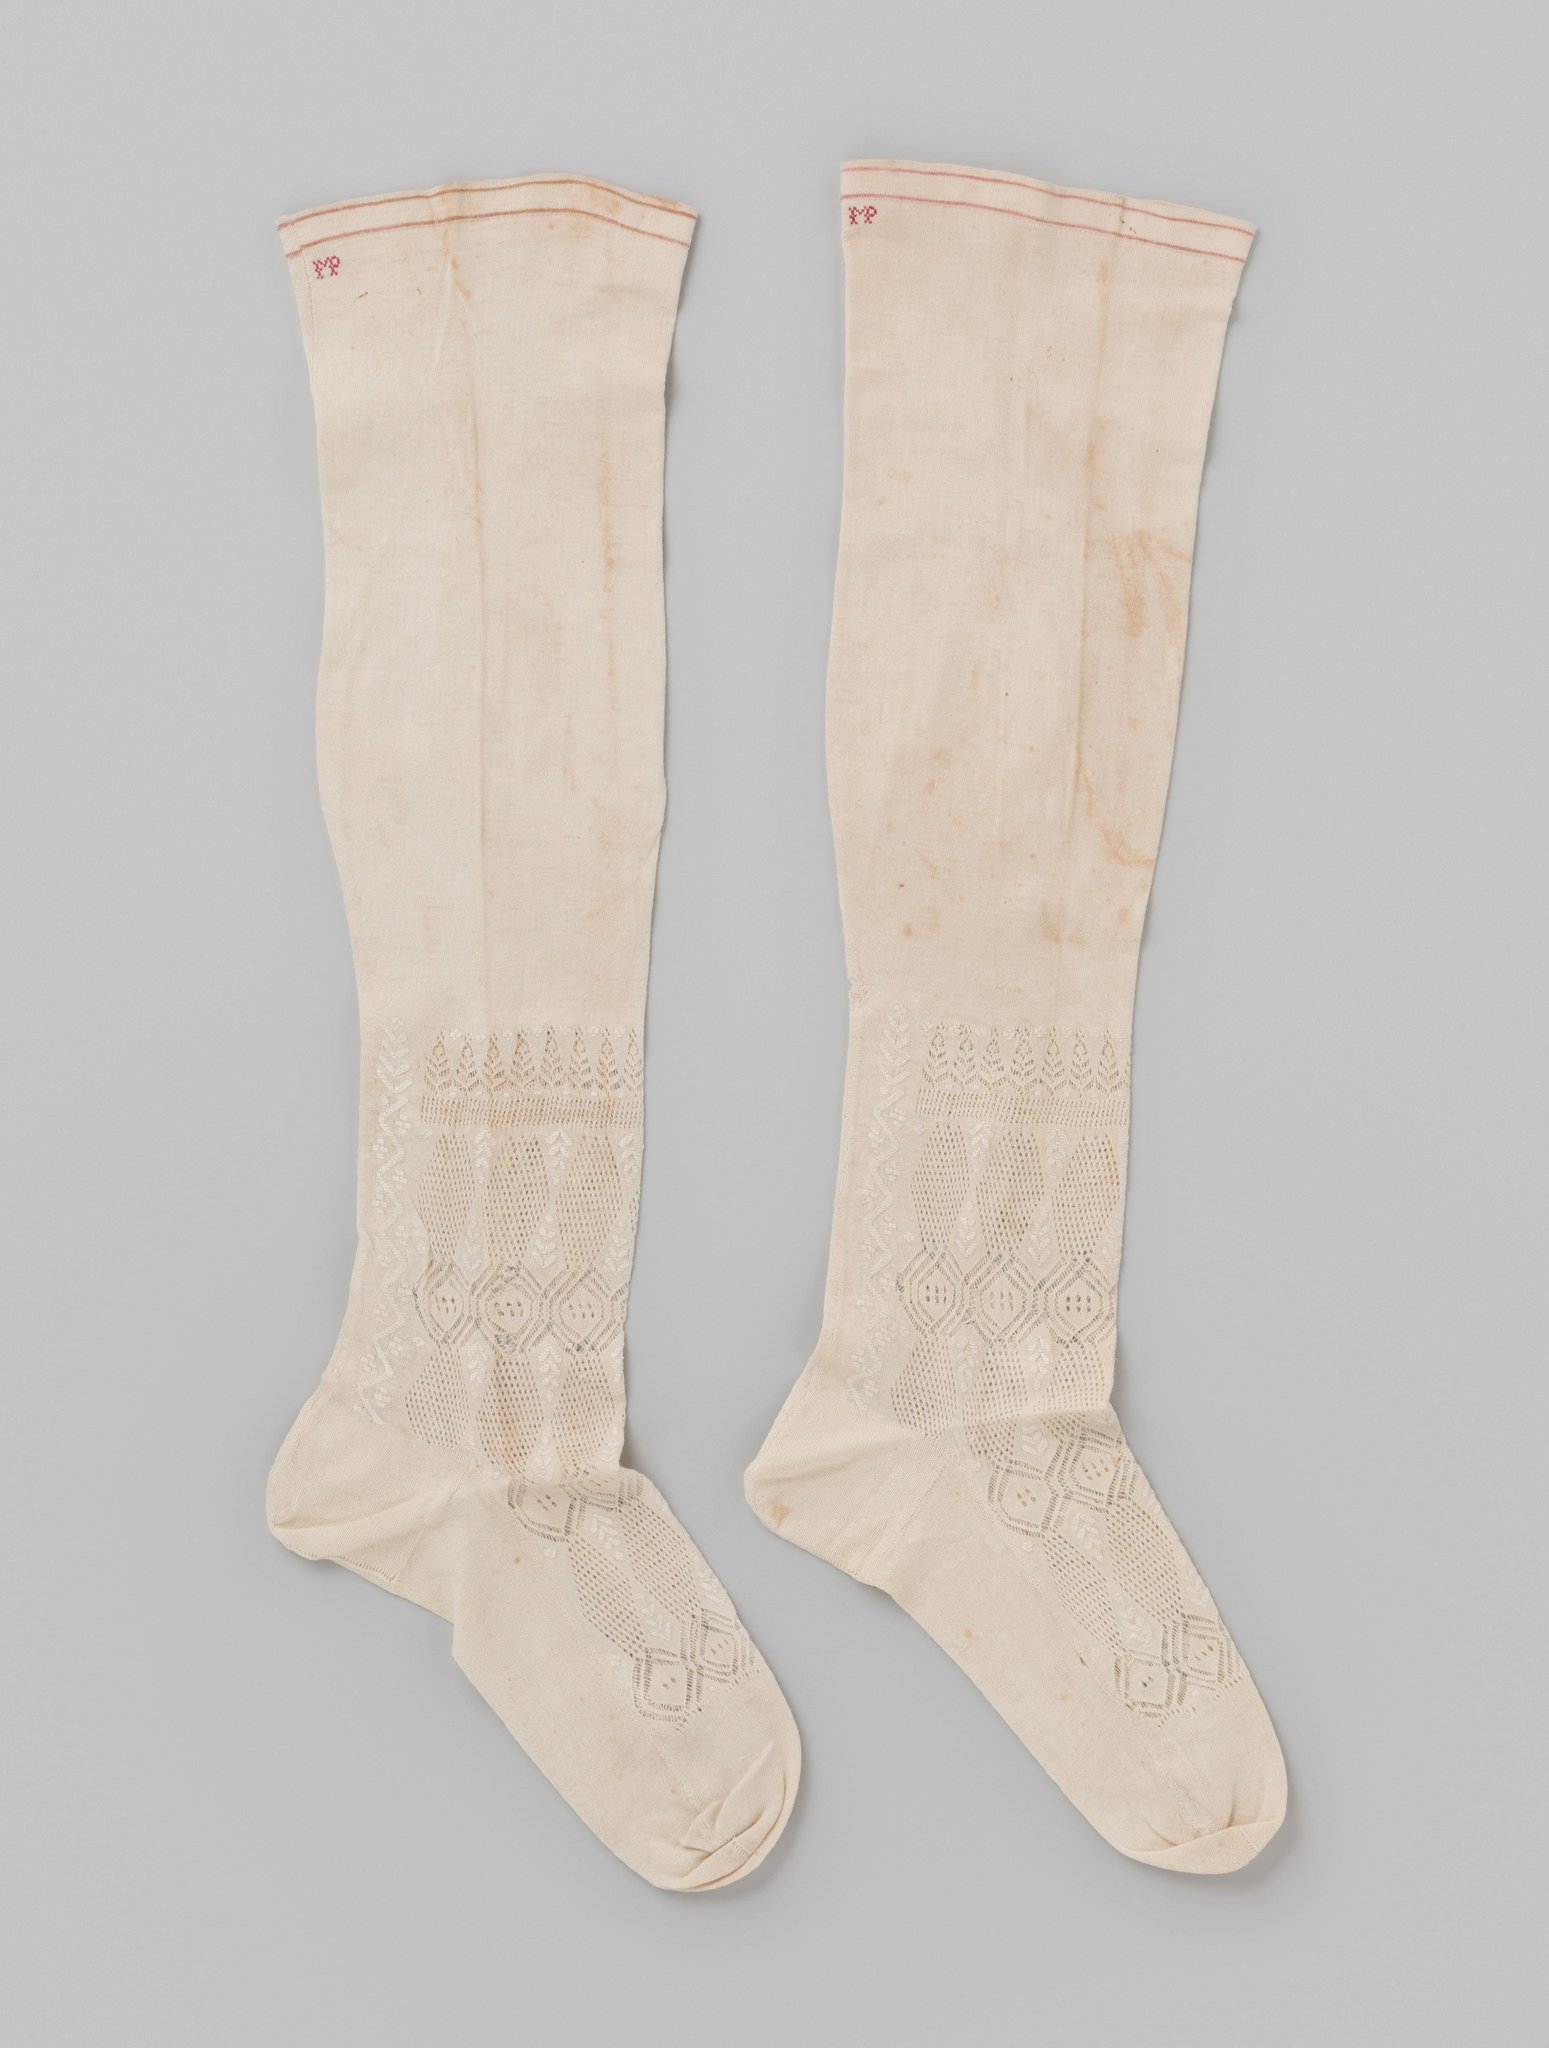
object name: clothing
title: Kous van witte katoen, met ajour gebreide en geborduurde geometrische versiering van klink en wreef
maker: Anonymous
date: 1800-1900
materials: cotton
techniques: embroidered, knitting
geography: netherlands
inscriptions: initials: ‘MP’, initials: ‘B’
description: Paar kousen van wit katoen. Ingebreide versiering van de wreef tot halverwege het scheenbeen, 'pattes'. Patroon van afwisselende dwarsbanden met ruitvormen en gerekte zeshoeken en eindigend in een rij kleine dennebomen. Ingebreid merk B en geborduurde merken MP.